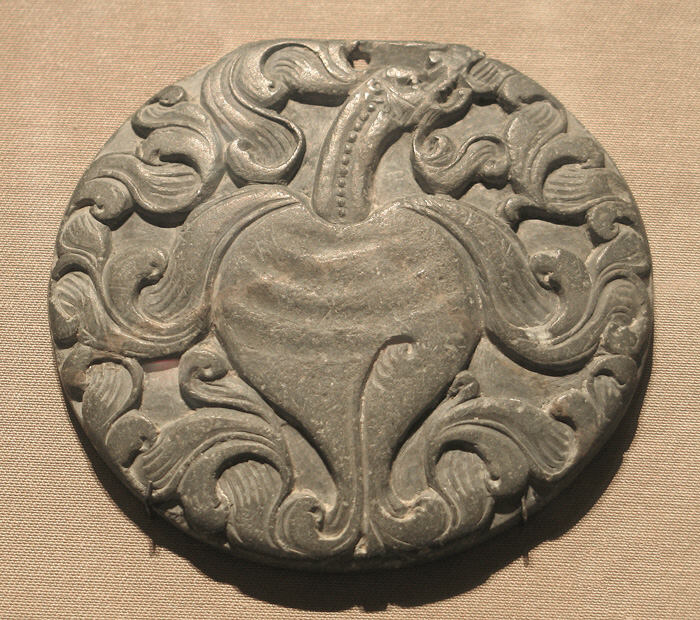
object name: box with lid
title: Box Lid with a Flower Bud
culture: gandhara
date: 401-500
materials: stone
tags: gandhara,flowers